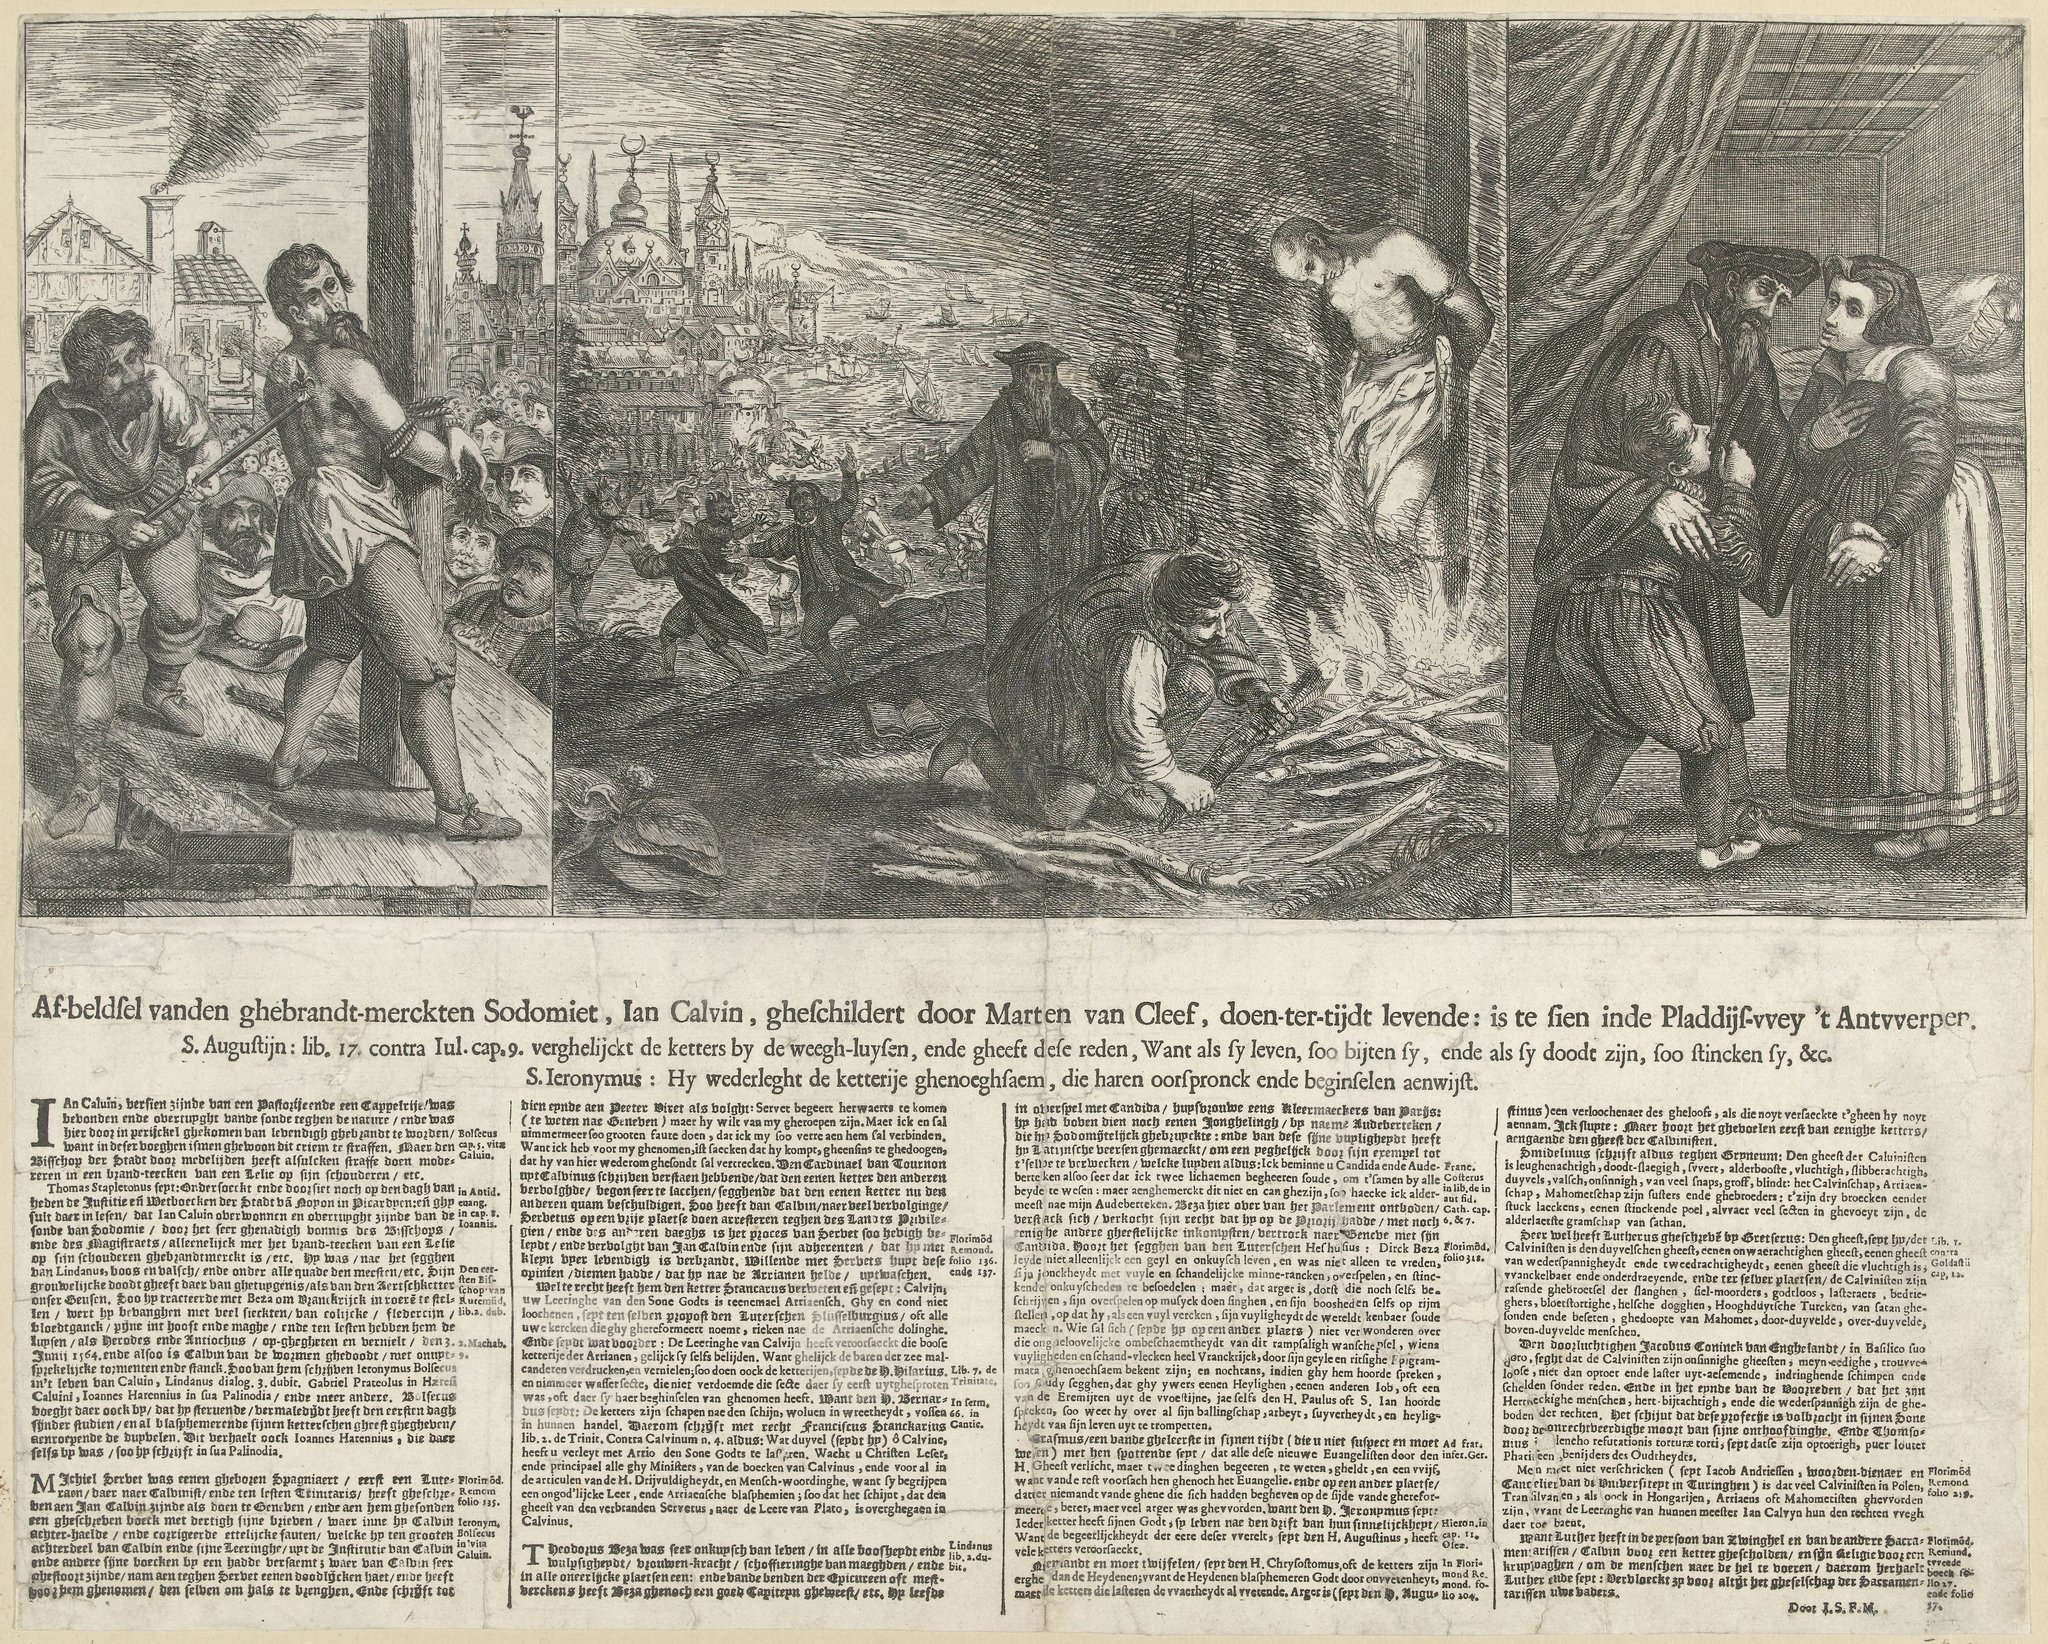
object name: cartoon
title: Triptiek met satirische scènes op de Protestanten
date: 1650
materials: paper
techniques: etching, letterpress printing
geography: antwerp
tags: theodorus beza, brand ~ punishment, sodomy, sexual contact between men, violent death by burning at the stake; pyre, political caricatures and satires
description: Drie anti-protestantse voorstellingen. Links wordt de van sodomie beschuldigde hervormer Johannes Calvijn met een lelie op zijn schouder gebrandmerkt. In het midden wordt Michael Servet door toedoen van Calvijn levend verbrand op de brandstapel. Geheel rechts voert de reformator Theodorus Beza een gesprek met een vrouw en heeft daarbij zijn arm om een kind heengeslagen. Onder de voorstelling staat een tekst in vier kolommen met een toelichting in het Nederlands.